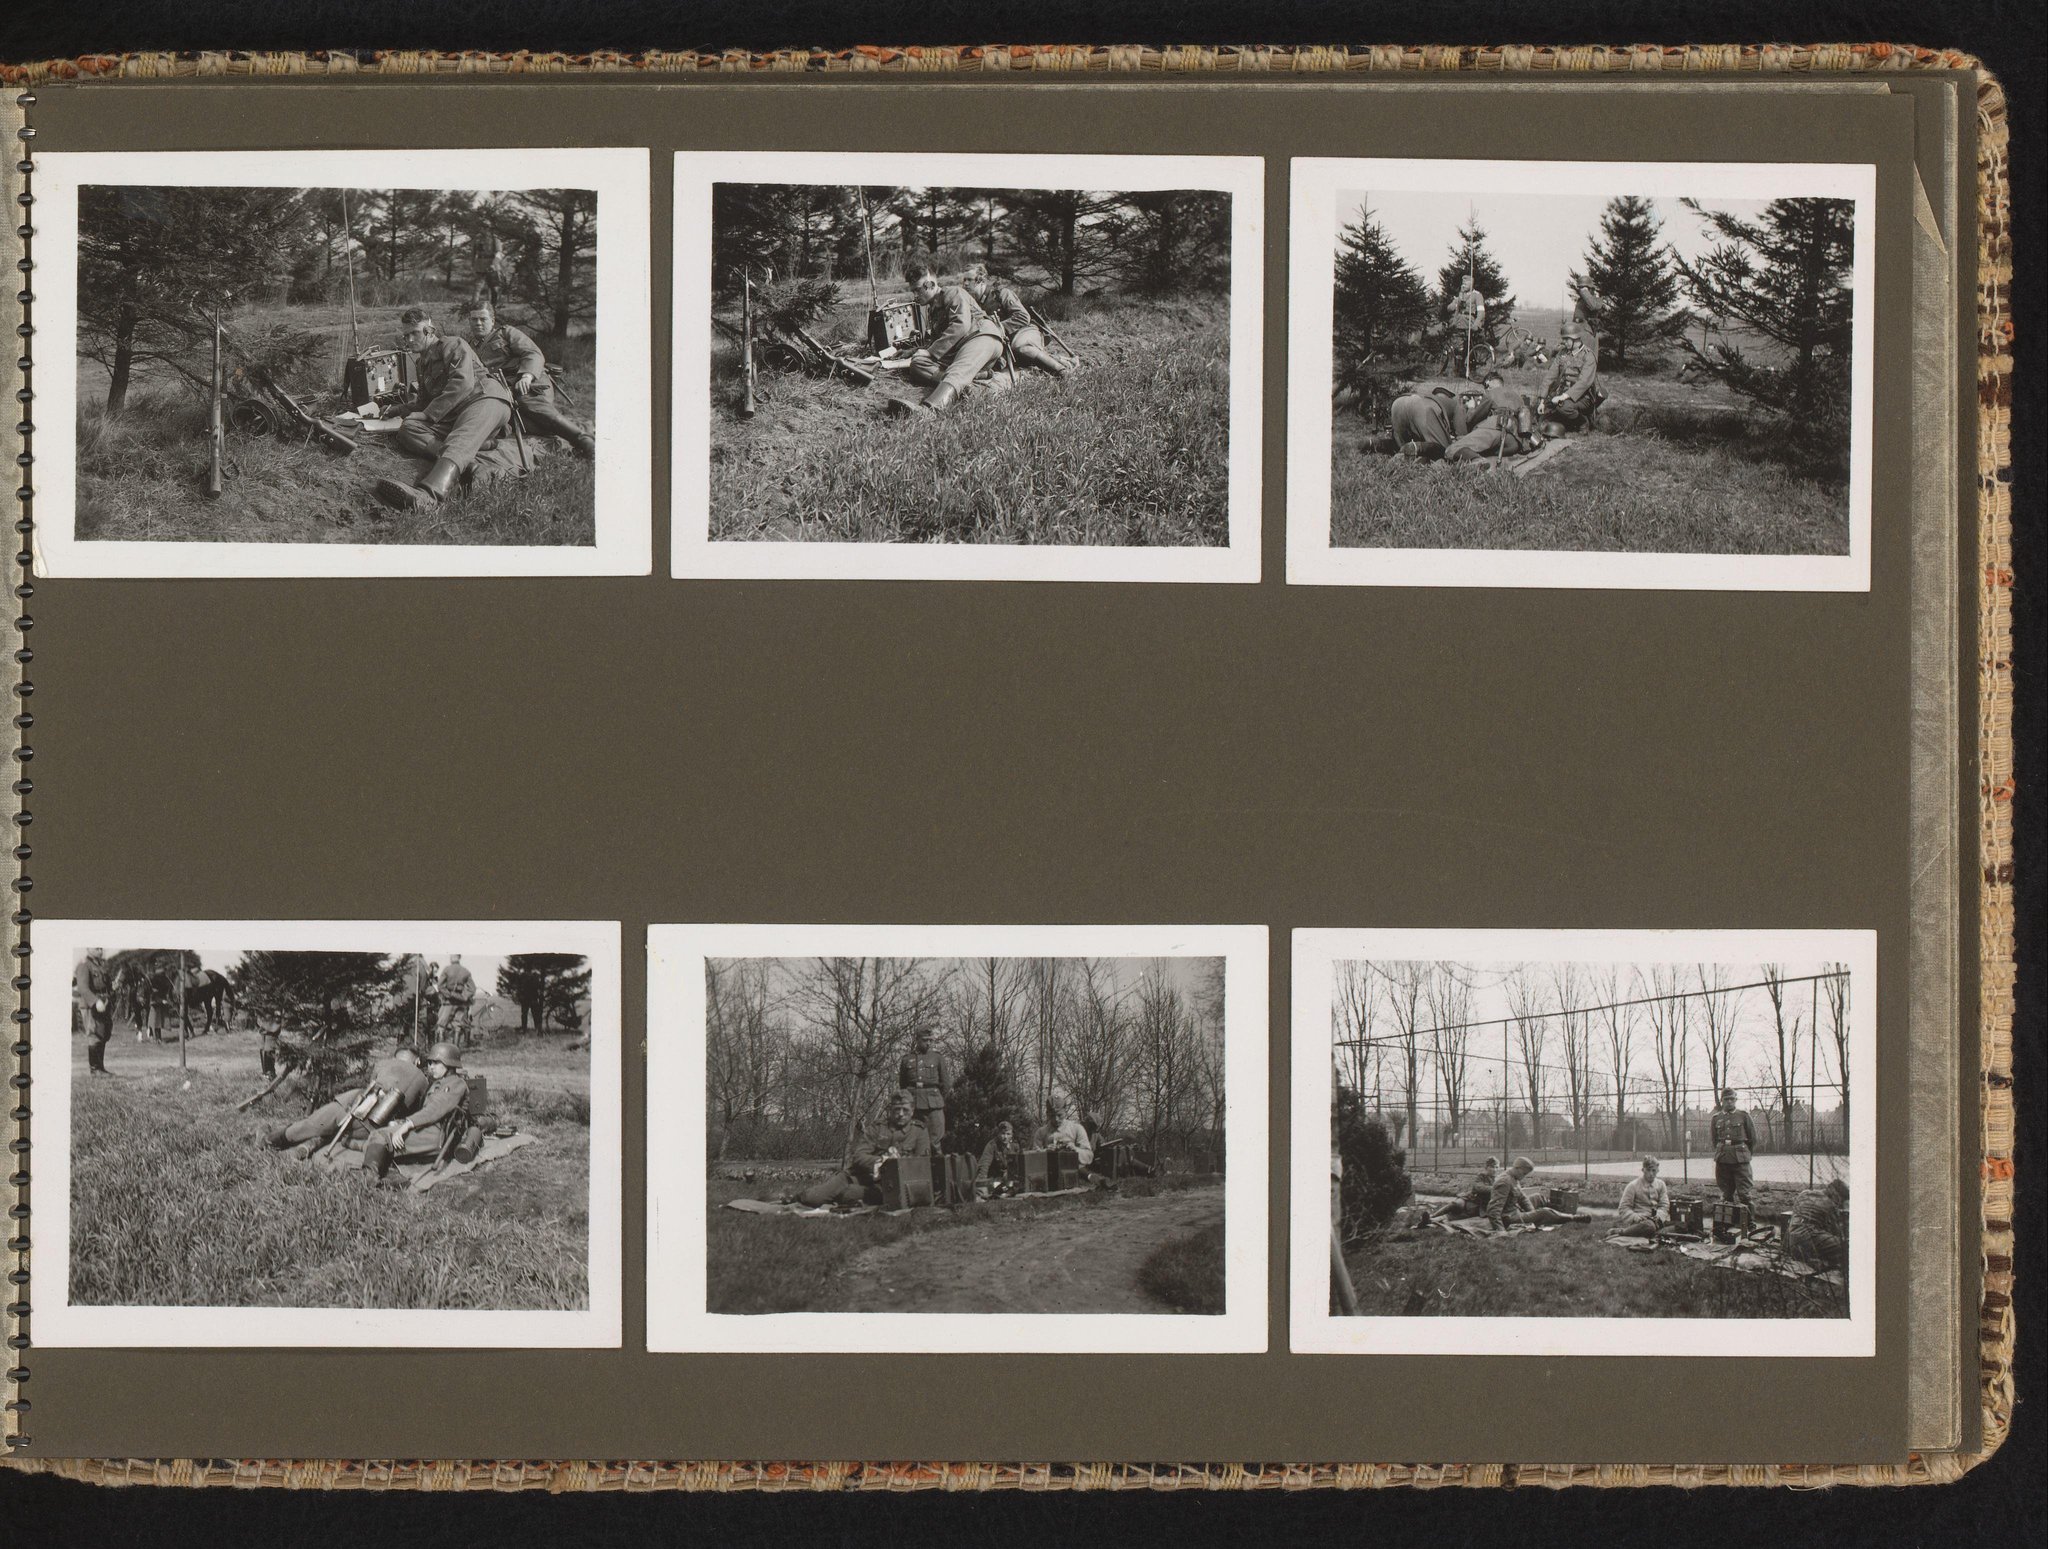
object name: album leaf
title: Oefenen met zendapparatuur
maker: Anonymous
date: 1940-1943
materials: cardboard, photographic support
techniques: gelatin silver print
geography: netherlands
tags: the company, the unit, the troop ~ military service, radio, wireless, radio broadcasting, military instruction, netherlands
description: Albumblad met zes foto's van een groep militairen bezig met oefenen met zendapparatuur. Oefeningen in het bos en in de stad. Onderdeel van het fotoalbum Duitse bezetting van Nederland.